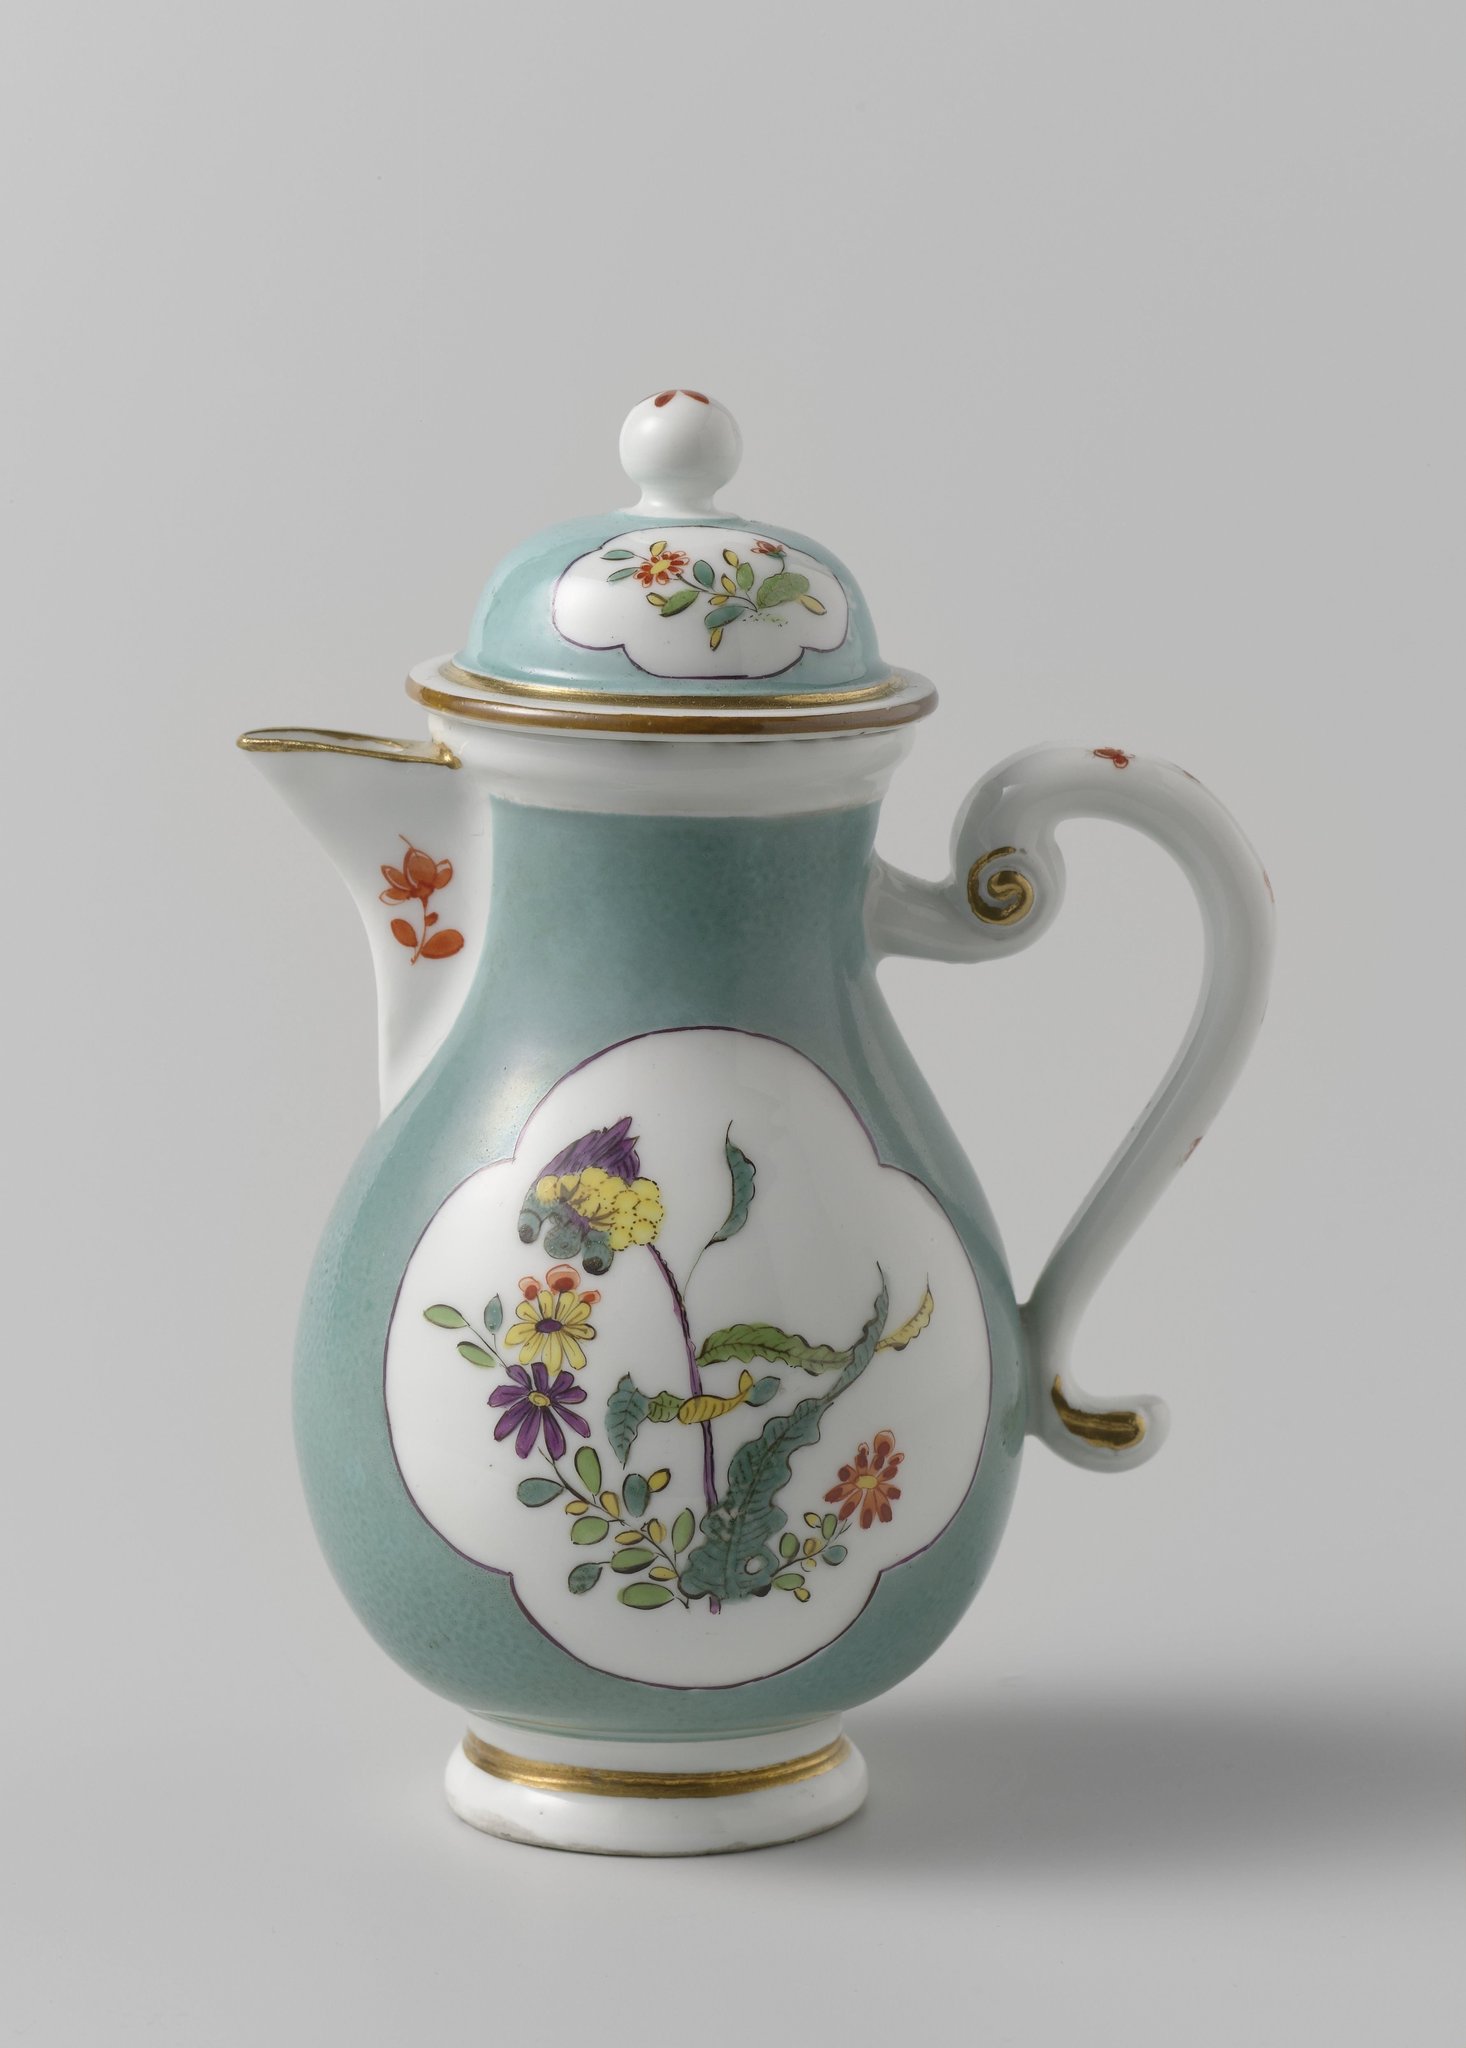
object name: milk jug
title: Melkkan, veelkleurig beschilderd met bloemtakken op een zeegroene fond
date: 1737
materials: porcelain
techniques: painted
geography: meissen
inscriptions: factory mark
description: Two jugs. Porcelain. Meissen, c. 1725 - 1730. Given by L. Mainz, 1938.